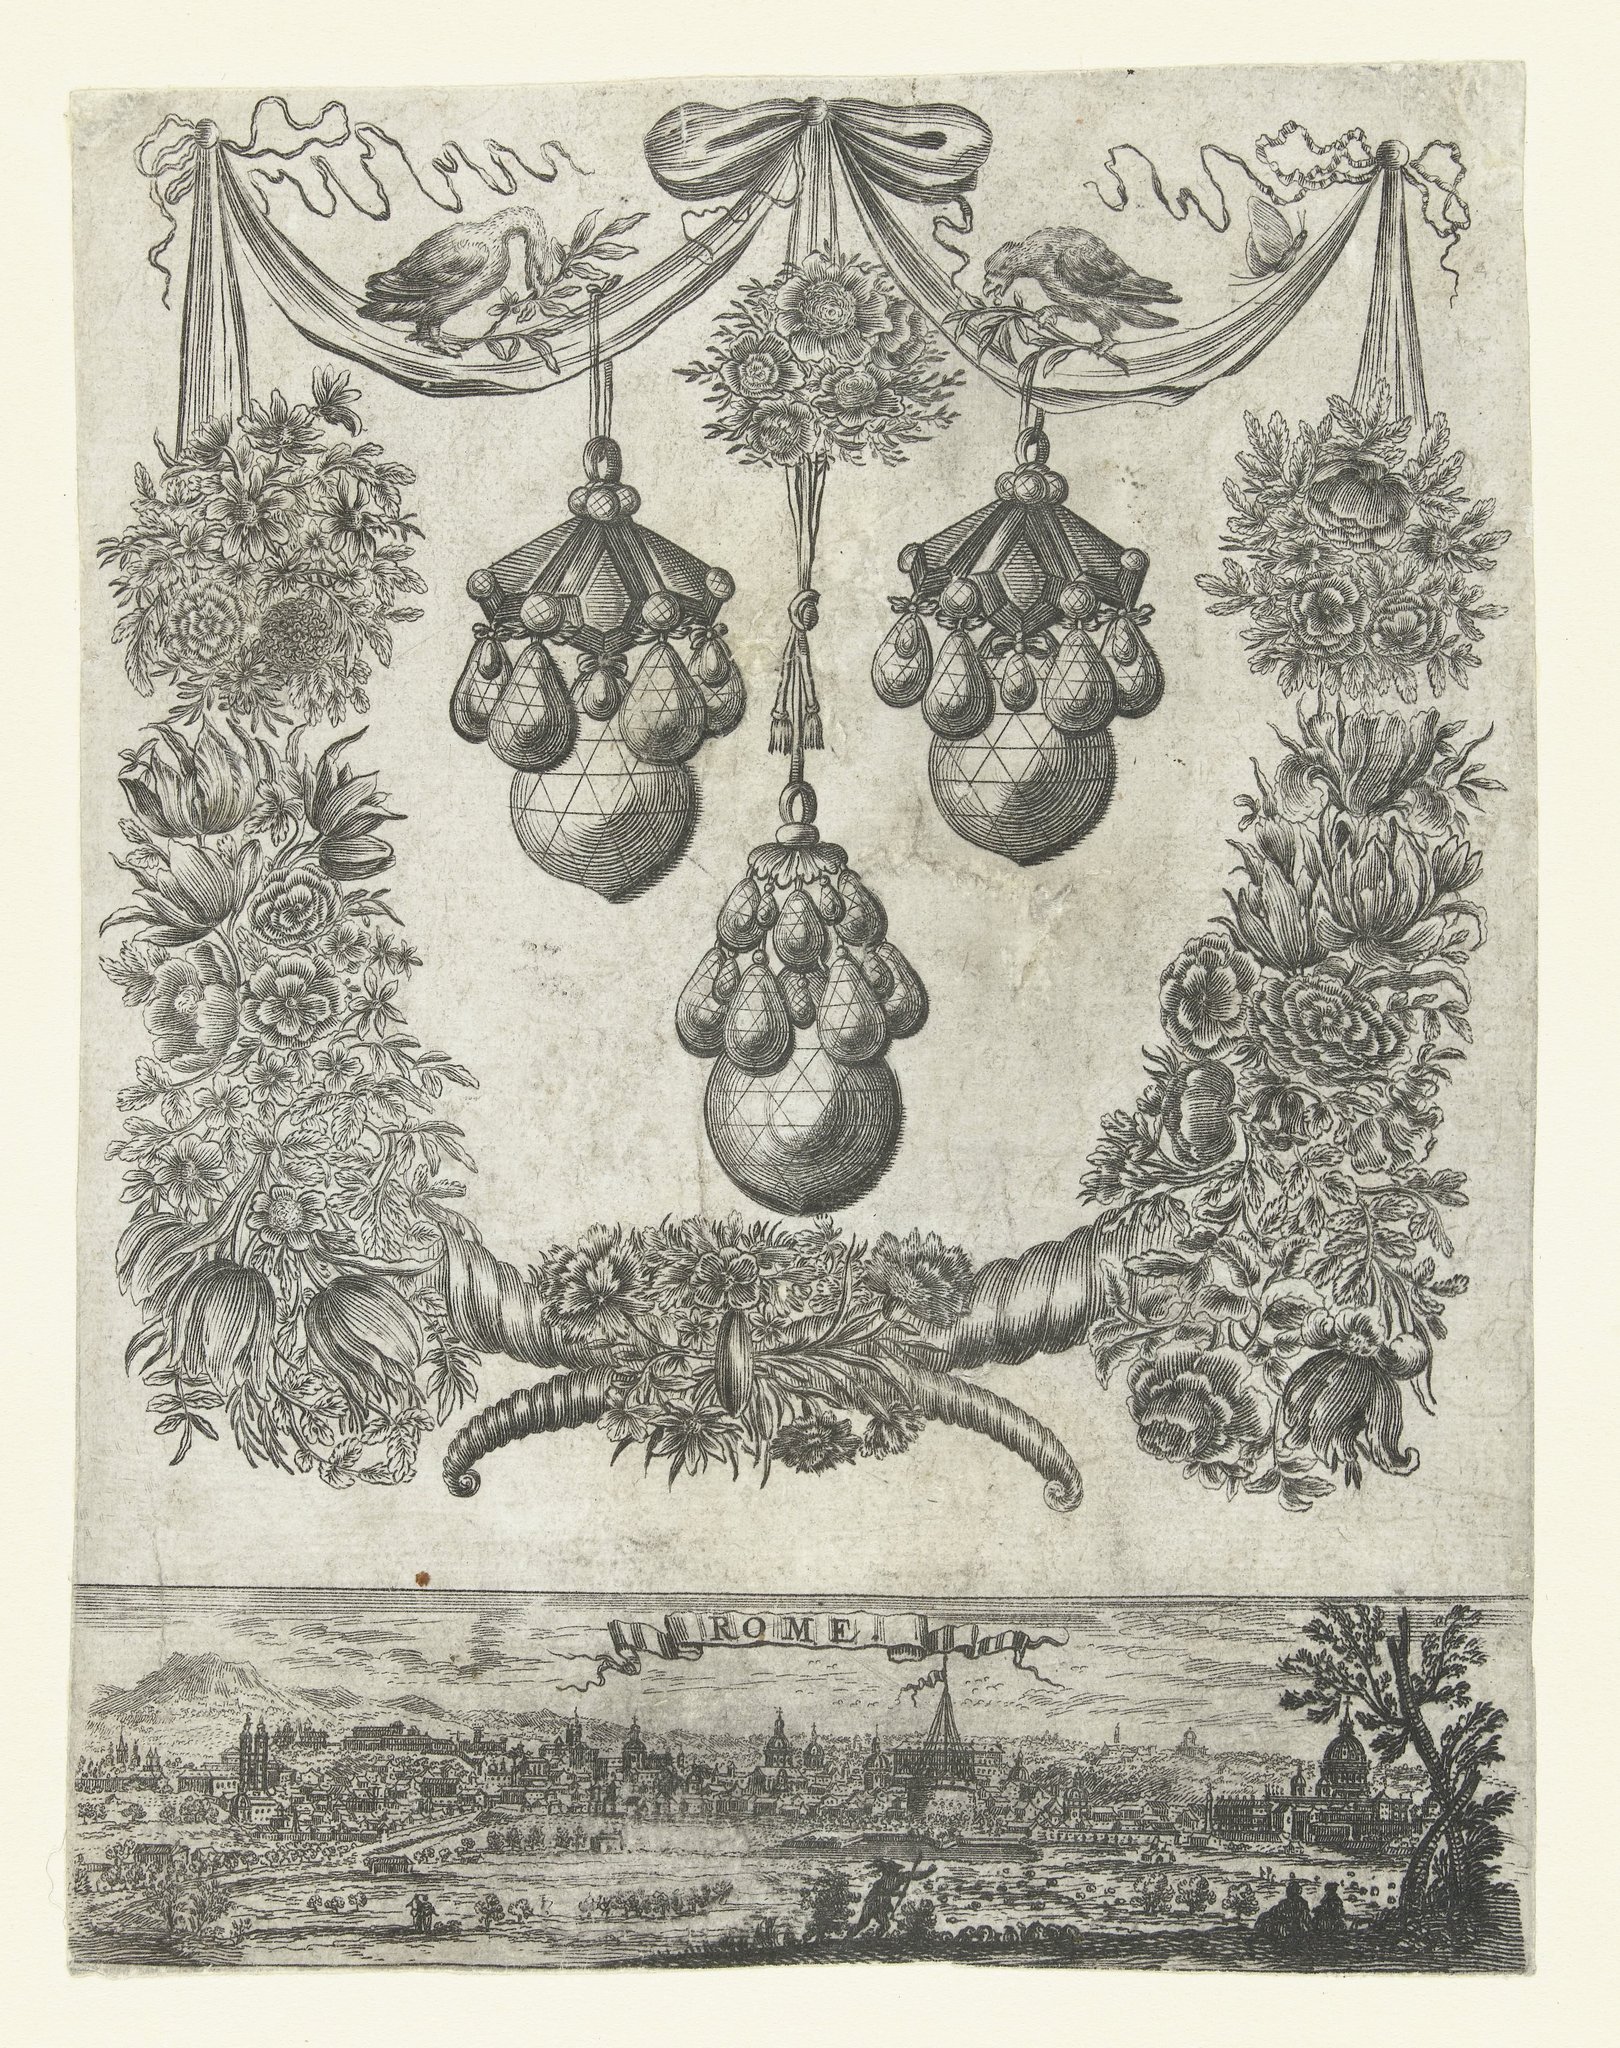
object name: print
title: Rome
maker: balthazar moncornet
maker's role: print maker, publisher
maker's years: 1600-1668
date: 1665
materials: paper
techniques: engraving, etching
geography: france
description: Cartouche opgebouwd uit een draperie met twee vogels en onderaan twee gekruiste hoorns des overvloeds, waarin drie oorbellen hangen. Uit serie van 12 bladen met ontwerpen van juwelen voor goudsmeden en emailleurs. Derde editie.